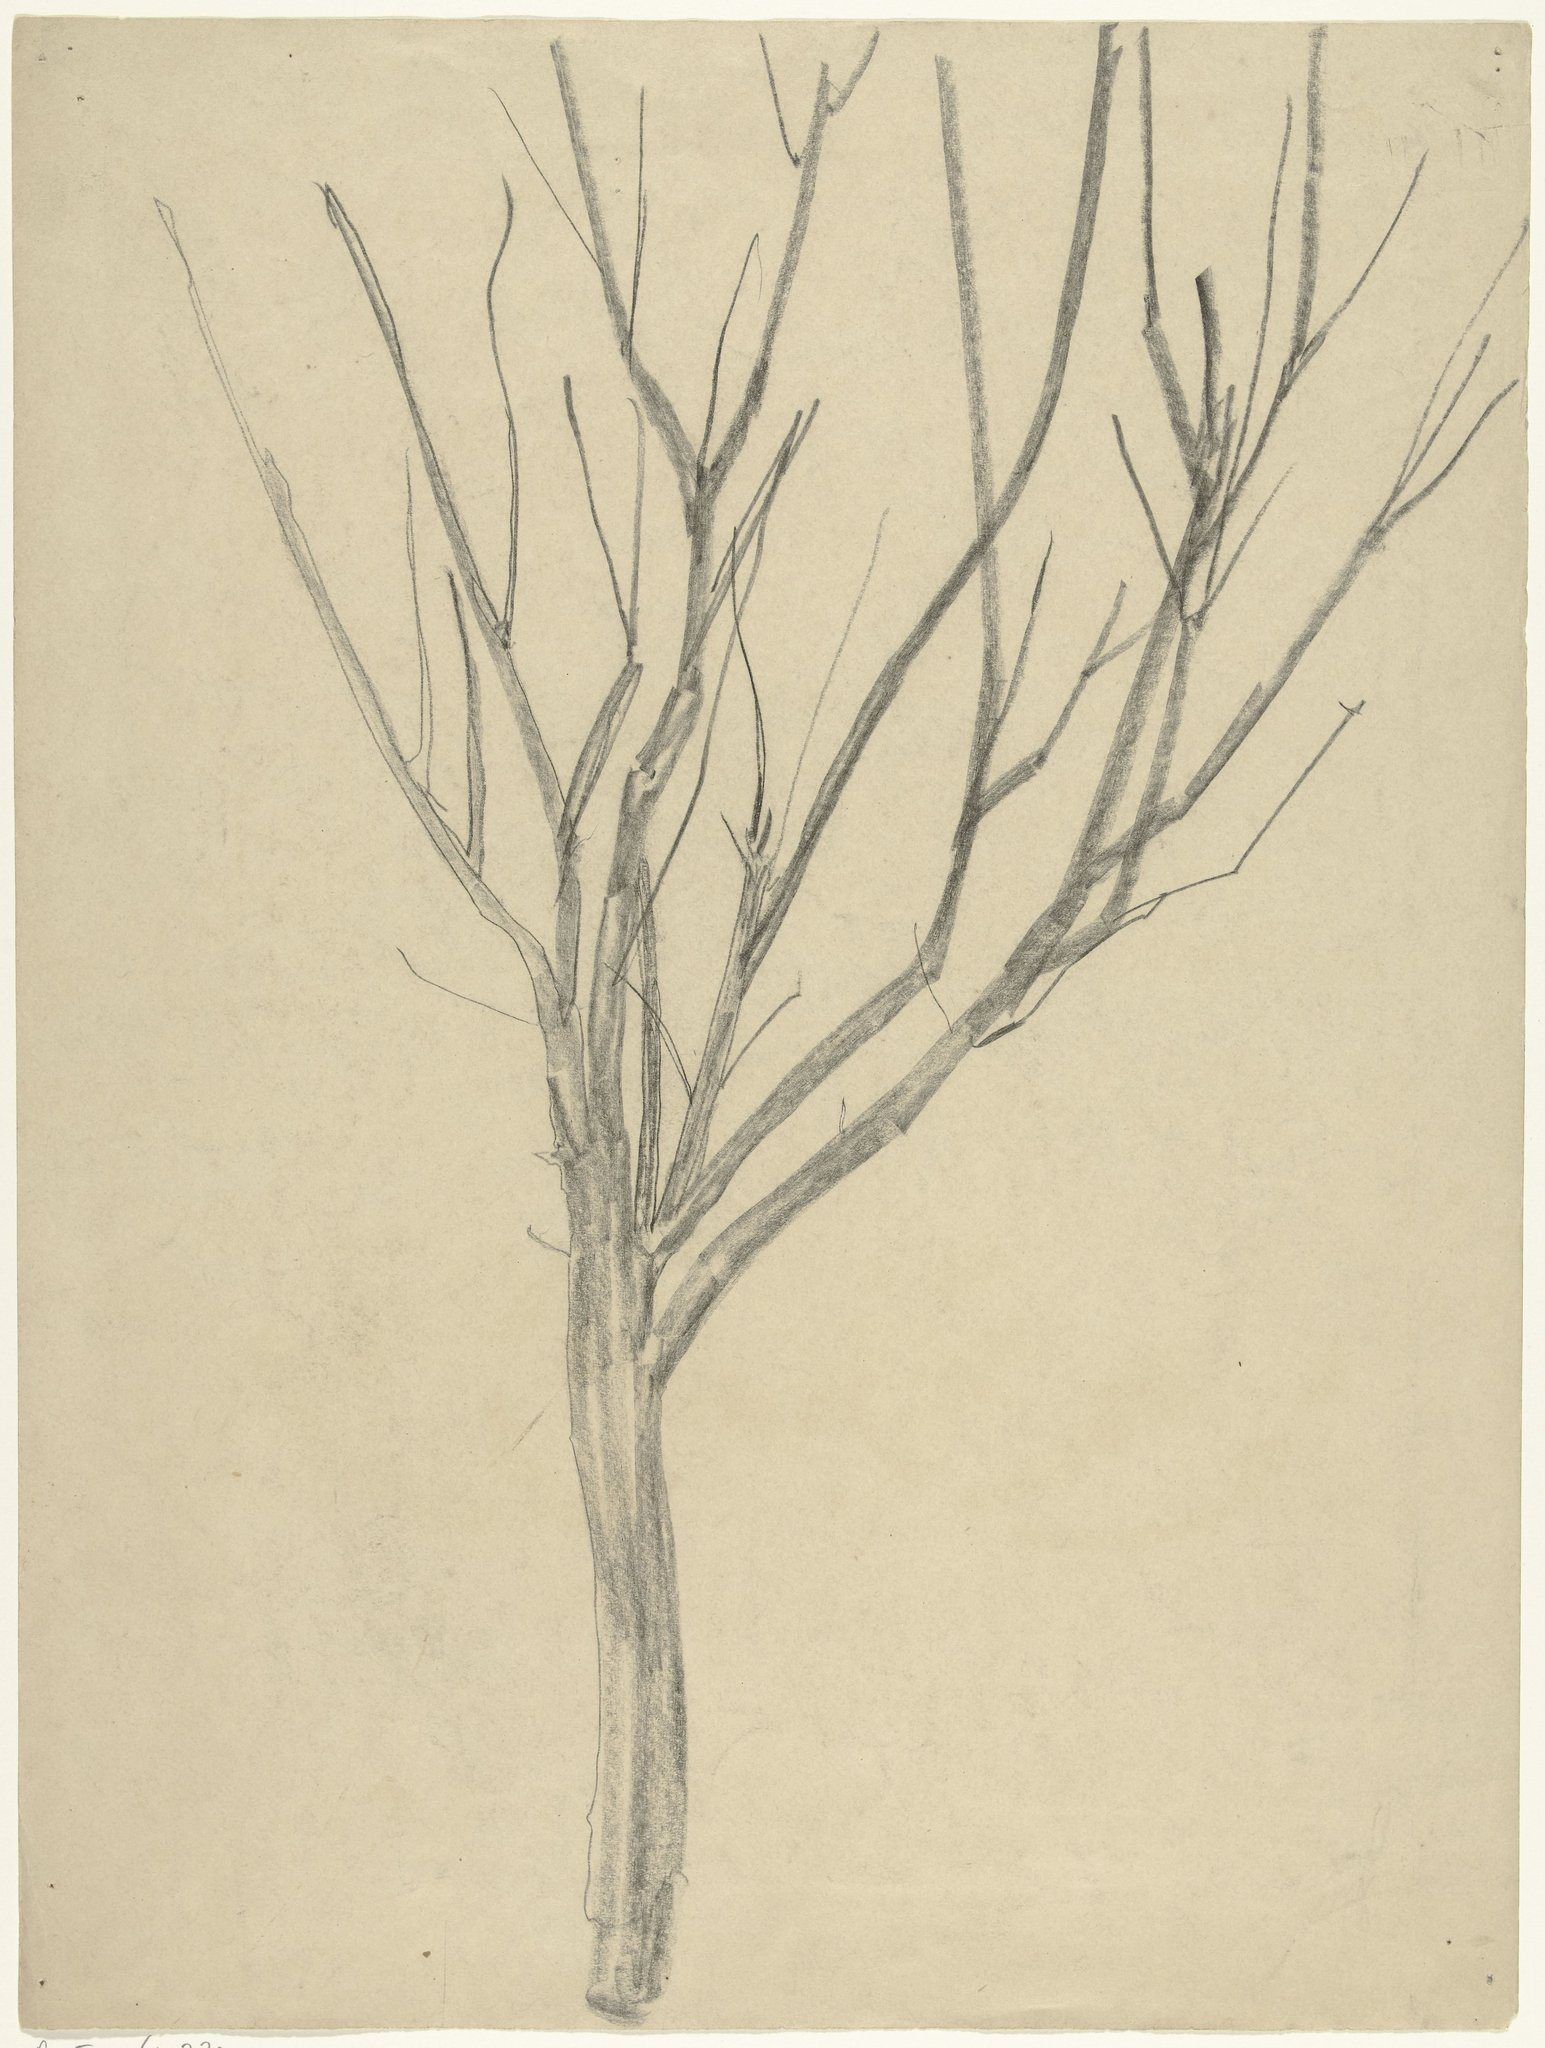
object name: drawing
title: Kale boom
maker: gerrit willem dijsselhof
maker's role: designer, draughtsman, print maker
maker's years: 1866-1924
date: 1876-1924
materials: chalk, paper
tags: trees